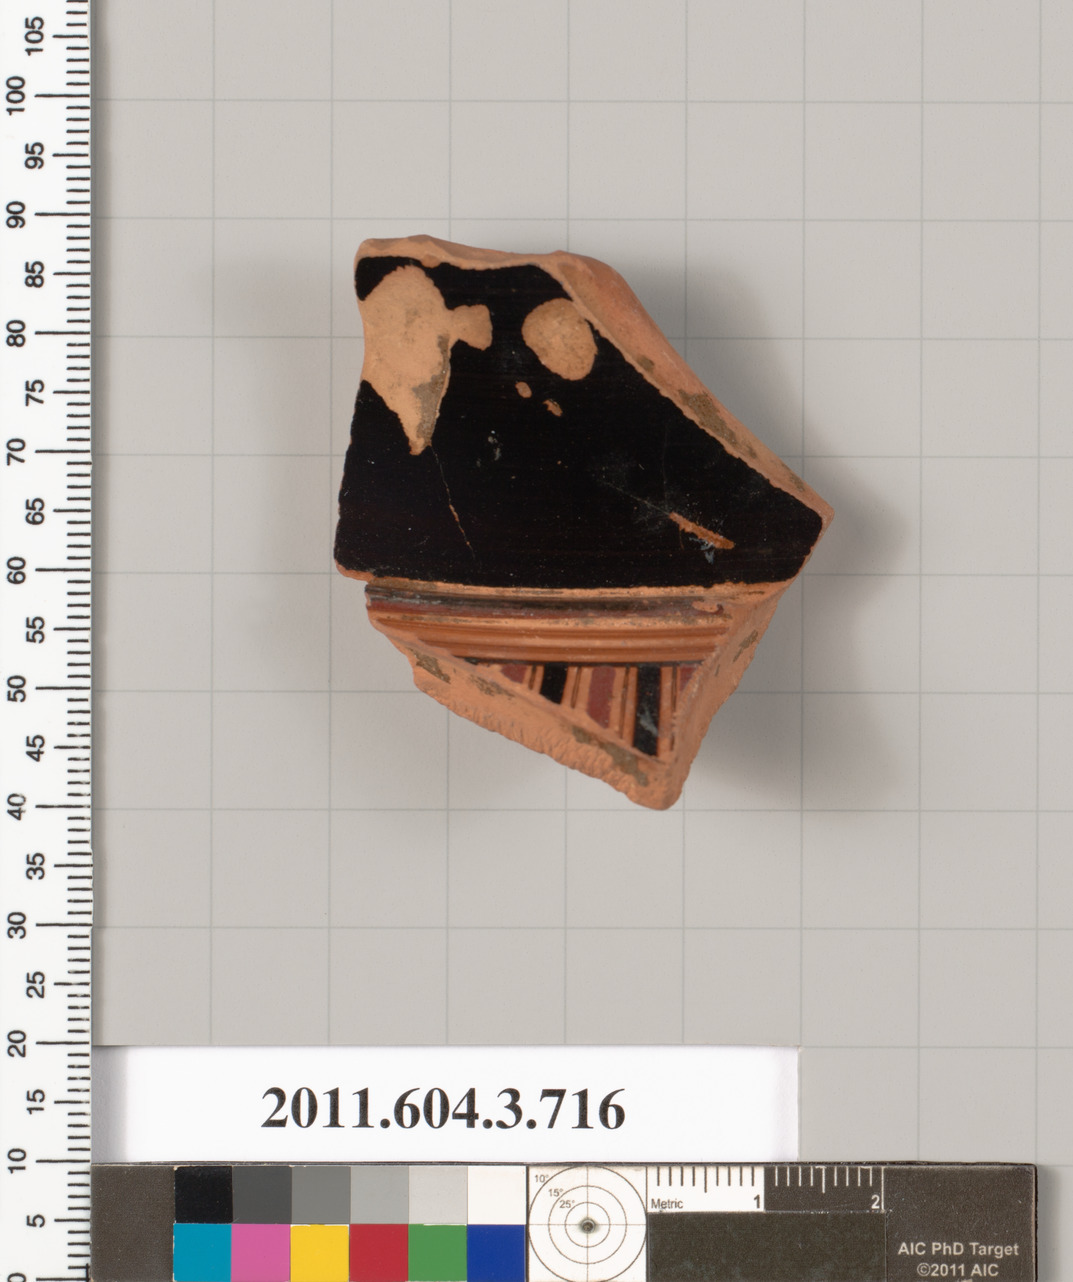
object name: hydria fragment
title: Terracotta fragment of a hydria (water jar)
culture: greek, attic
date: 550-540 BCE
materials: terracotta